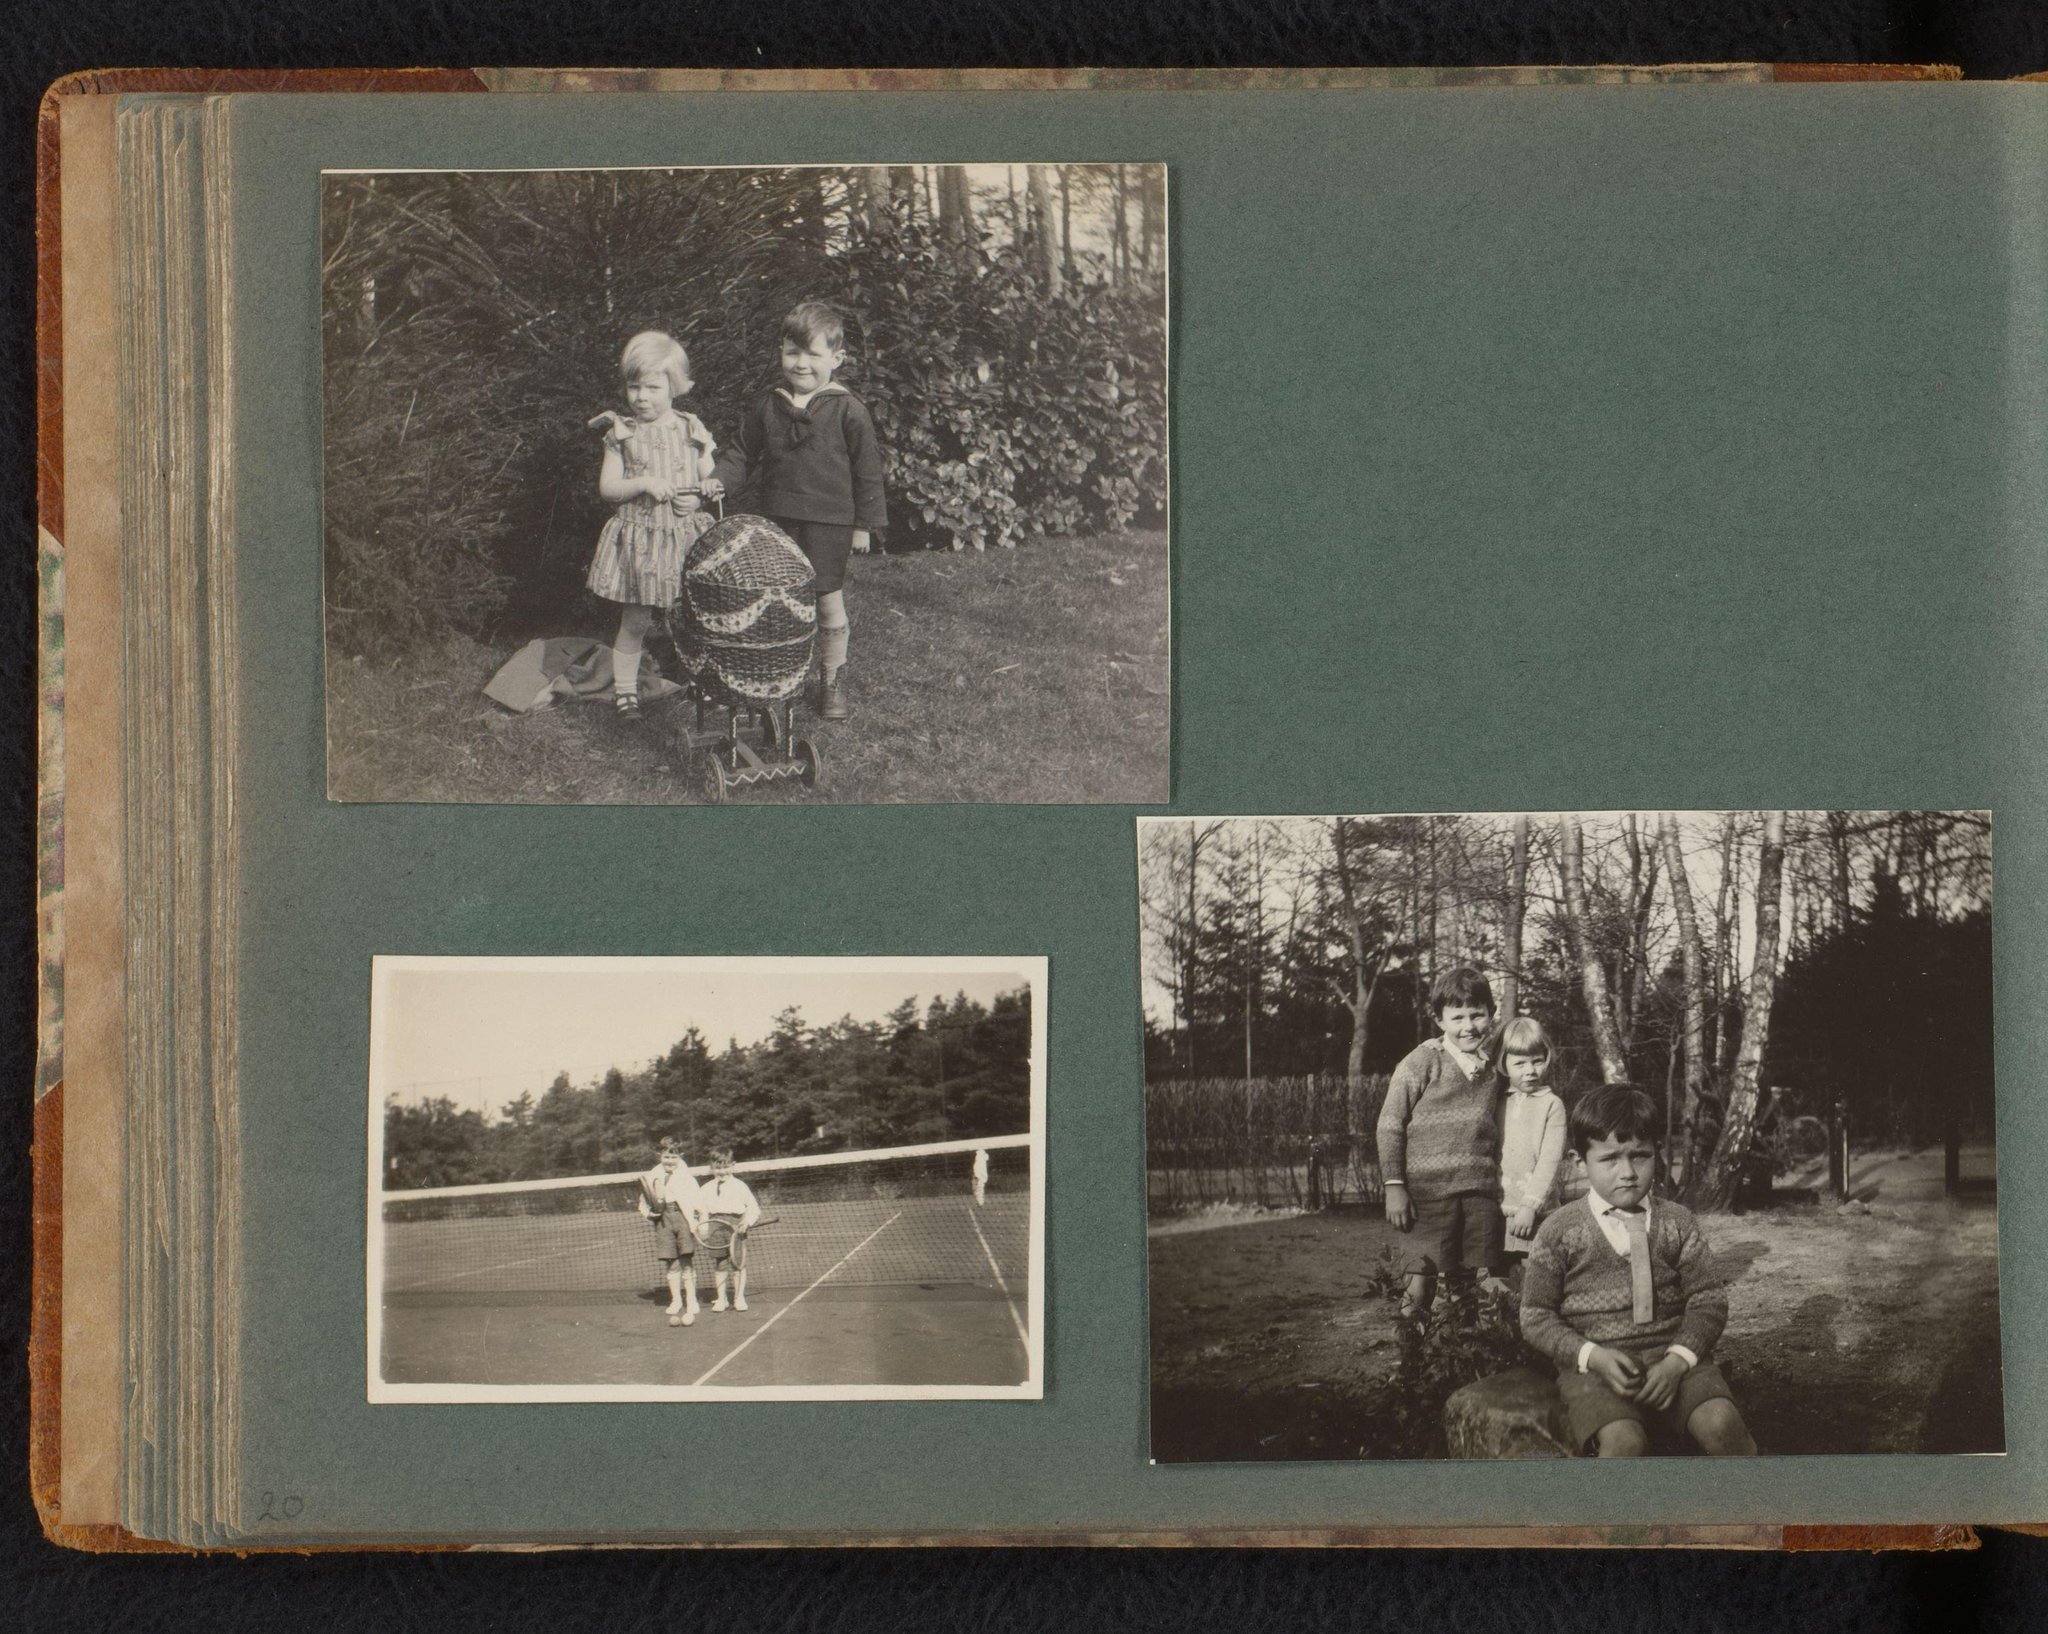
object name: album leaf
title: Drie foto's van Frank en Pieter Furnée en een ander kind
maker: Anonymous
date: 1920-1930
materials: paper, cardboard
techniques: gelatin silver print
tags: tennis, lawn-tennis, child, historical persons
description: Deze foto's maken deel uit van een album.